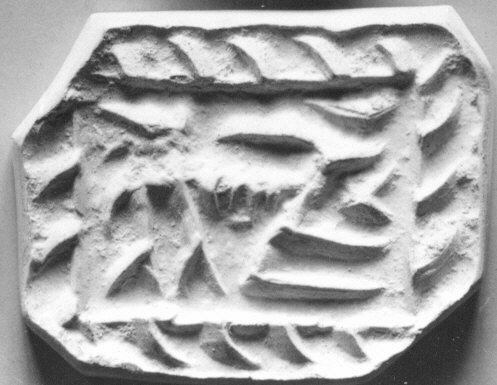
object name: stamp seal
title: Gable seal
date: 4000-3500 BCE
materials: mineral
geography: northern syria or southeastern anatolia